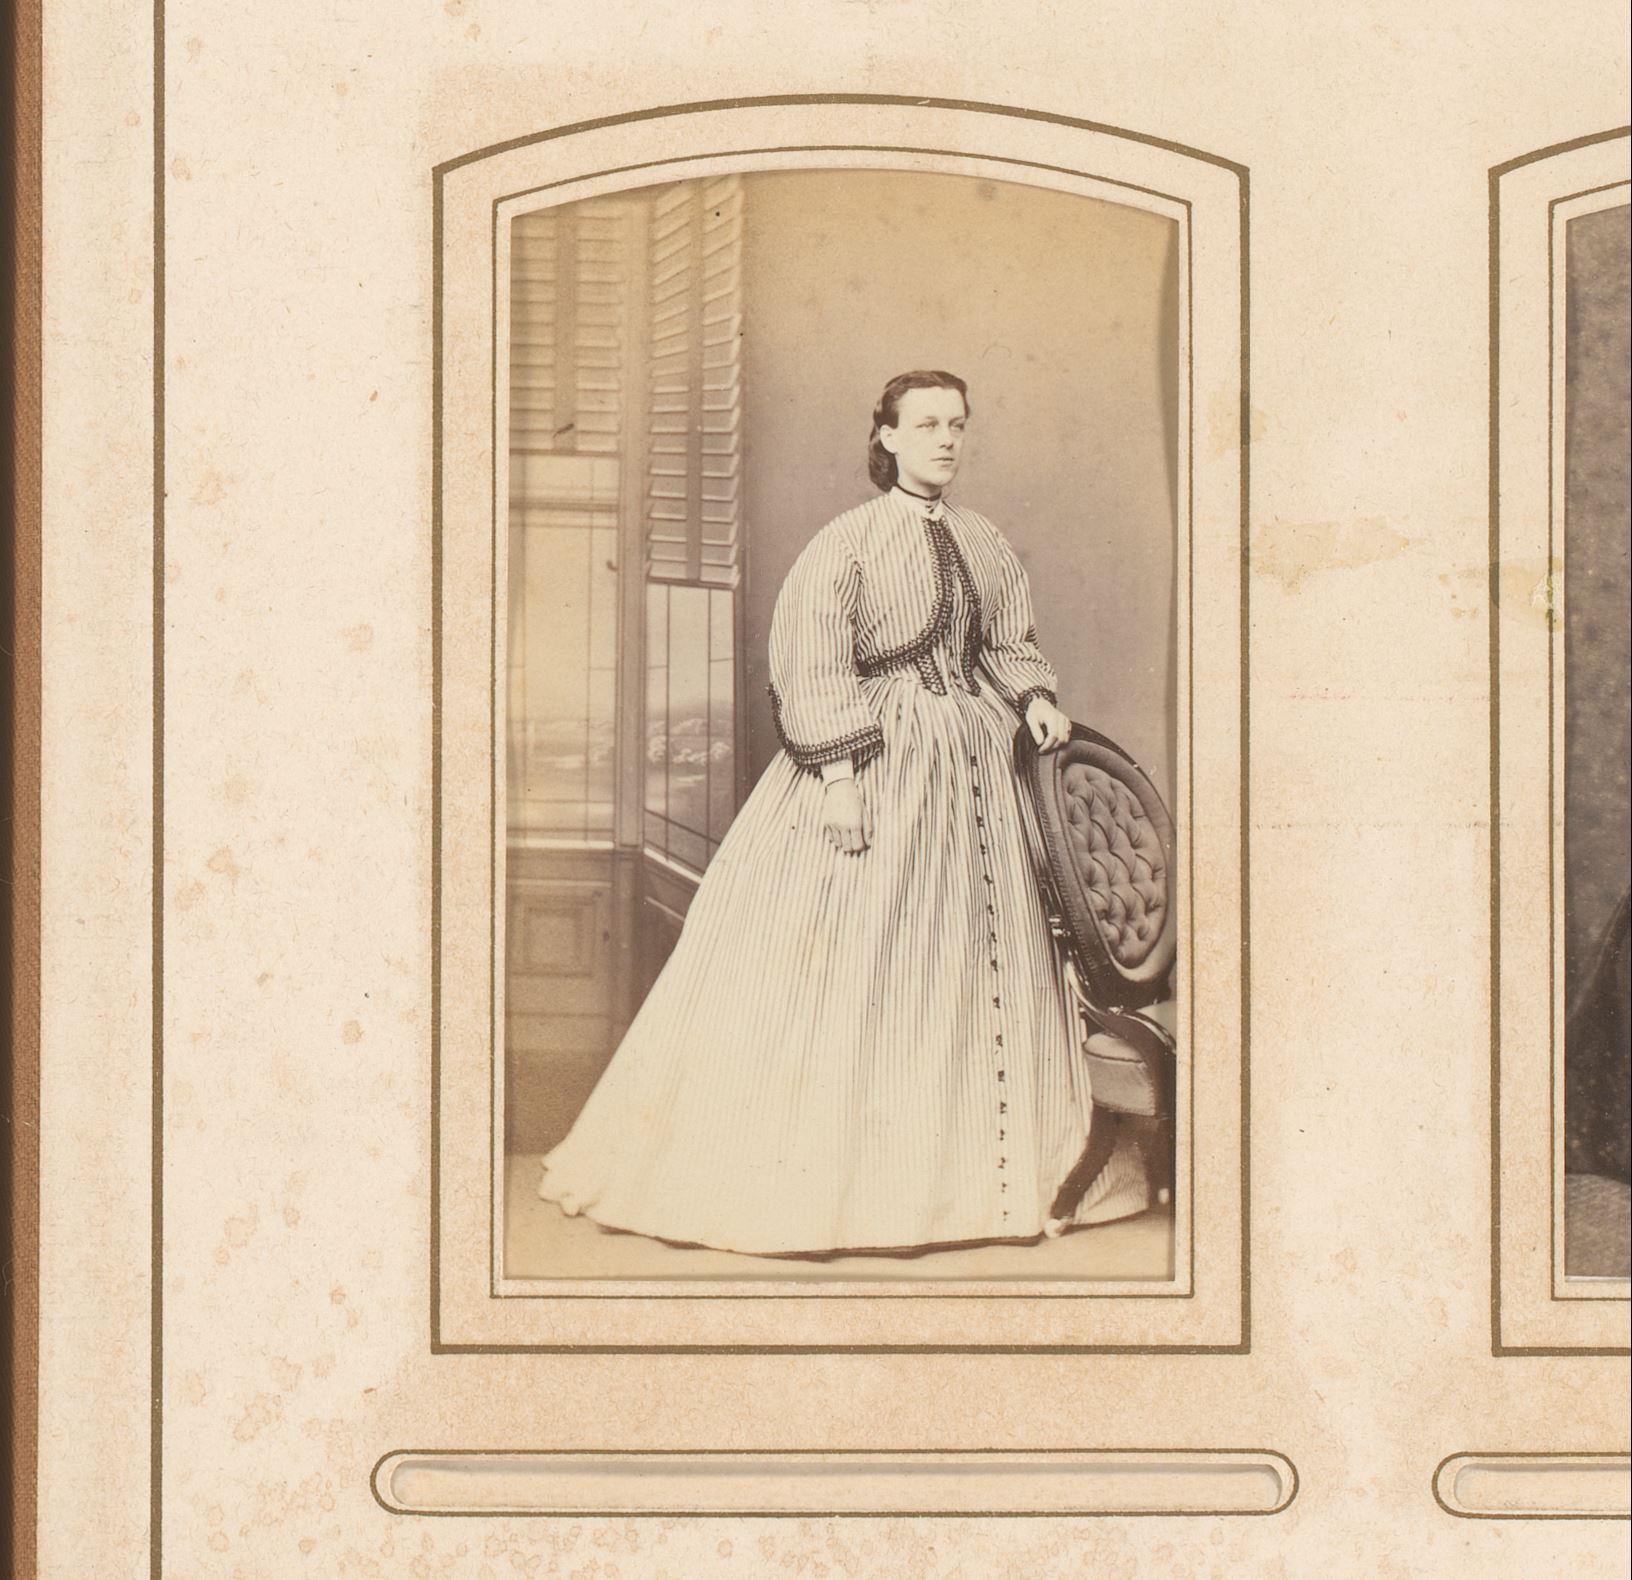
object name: album leaf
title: Portret van een vrouw in een gestreepte jurk, leunend op een stoel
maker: j. ballantine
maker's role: fotograaf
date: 1872-1873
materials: cardboard, paper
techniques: albumen print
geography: cumnock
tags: historical persons - bb - woman, chair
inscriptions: inscription: ‘J. Ballantine/ PHOTOGRAPHER/ CUMNOCK’